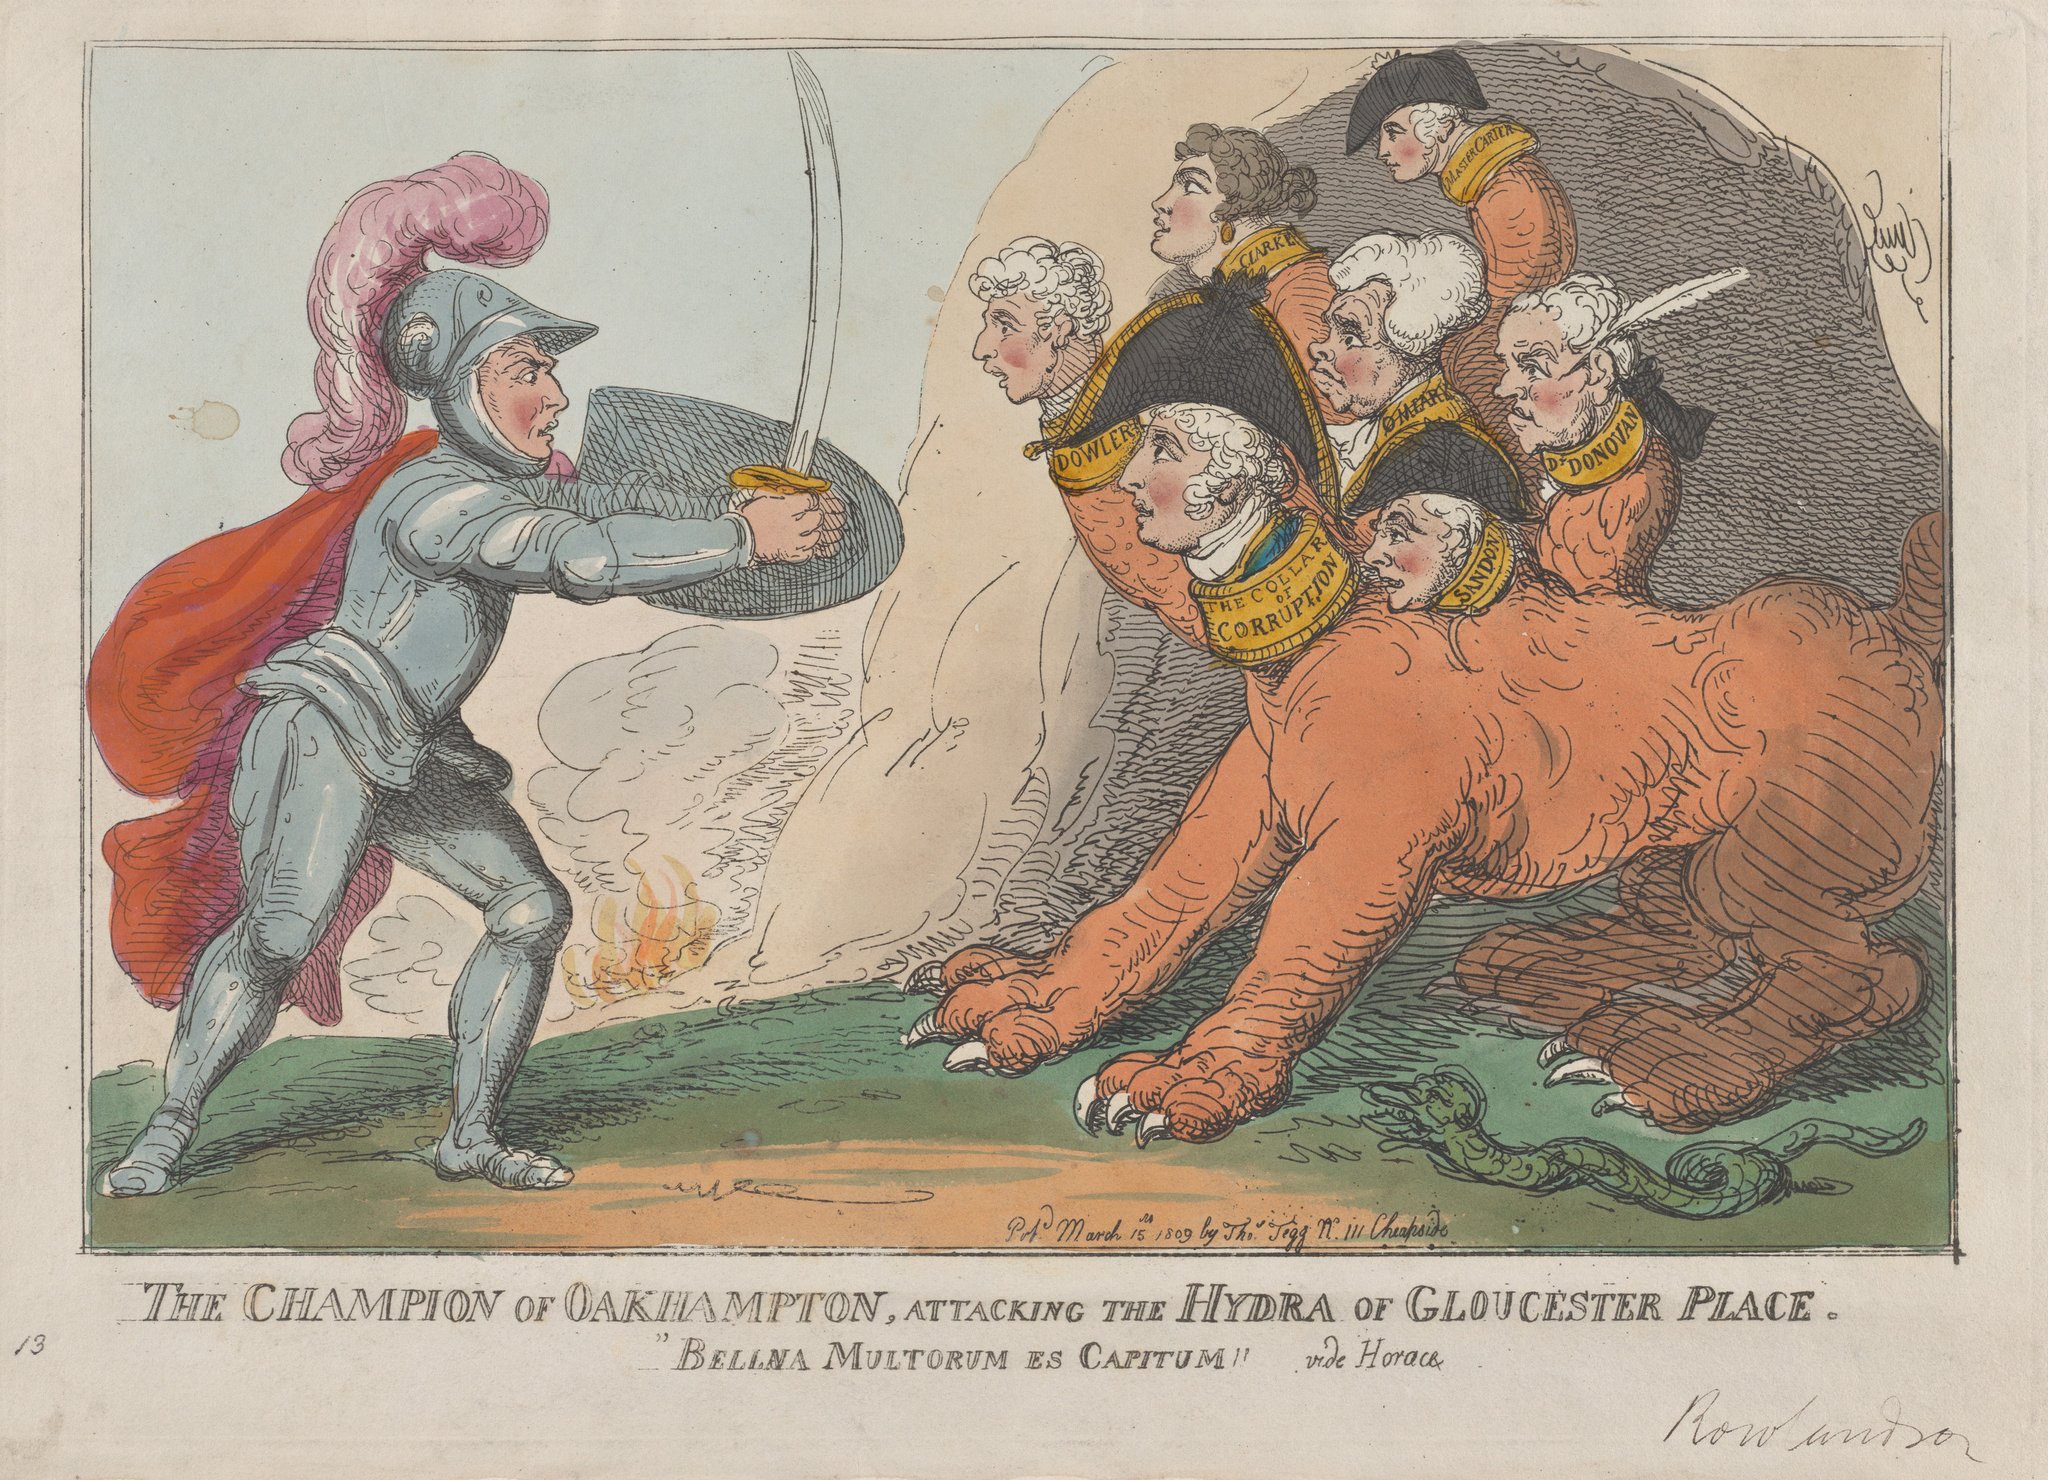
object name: print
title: The Champion of Oakhampton, Attacking the Hydra of Gloucester Place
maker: thomas rowlandson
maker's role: artist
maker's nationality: british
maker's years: 1757-1827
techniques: etching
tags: satire,men,politics